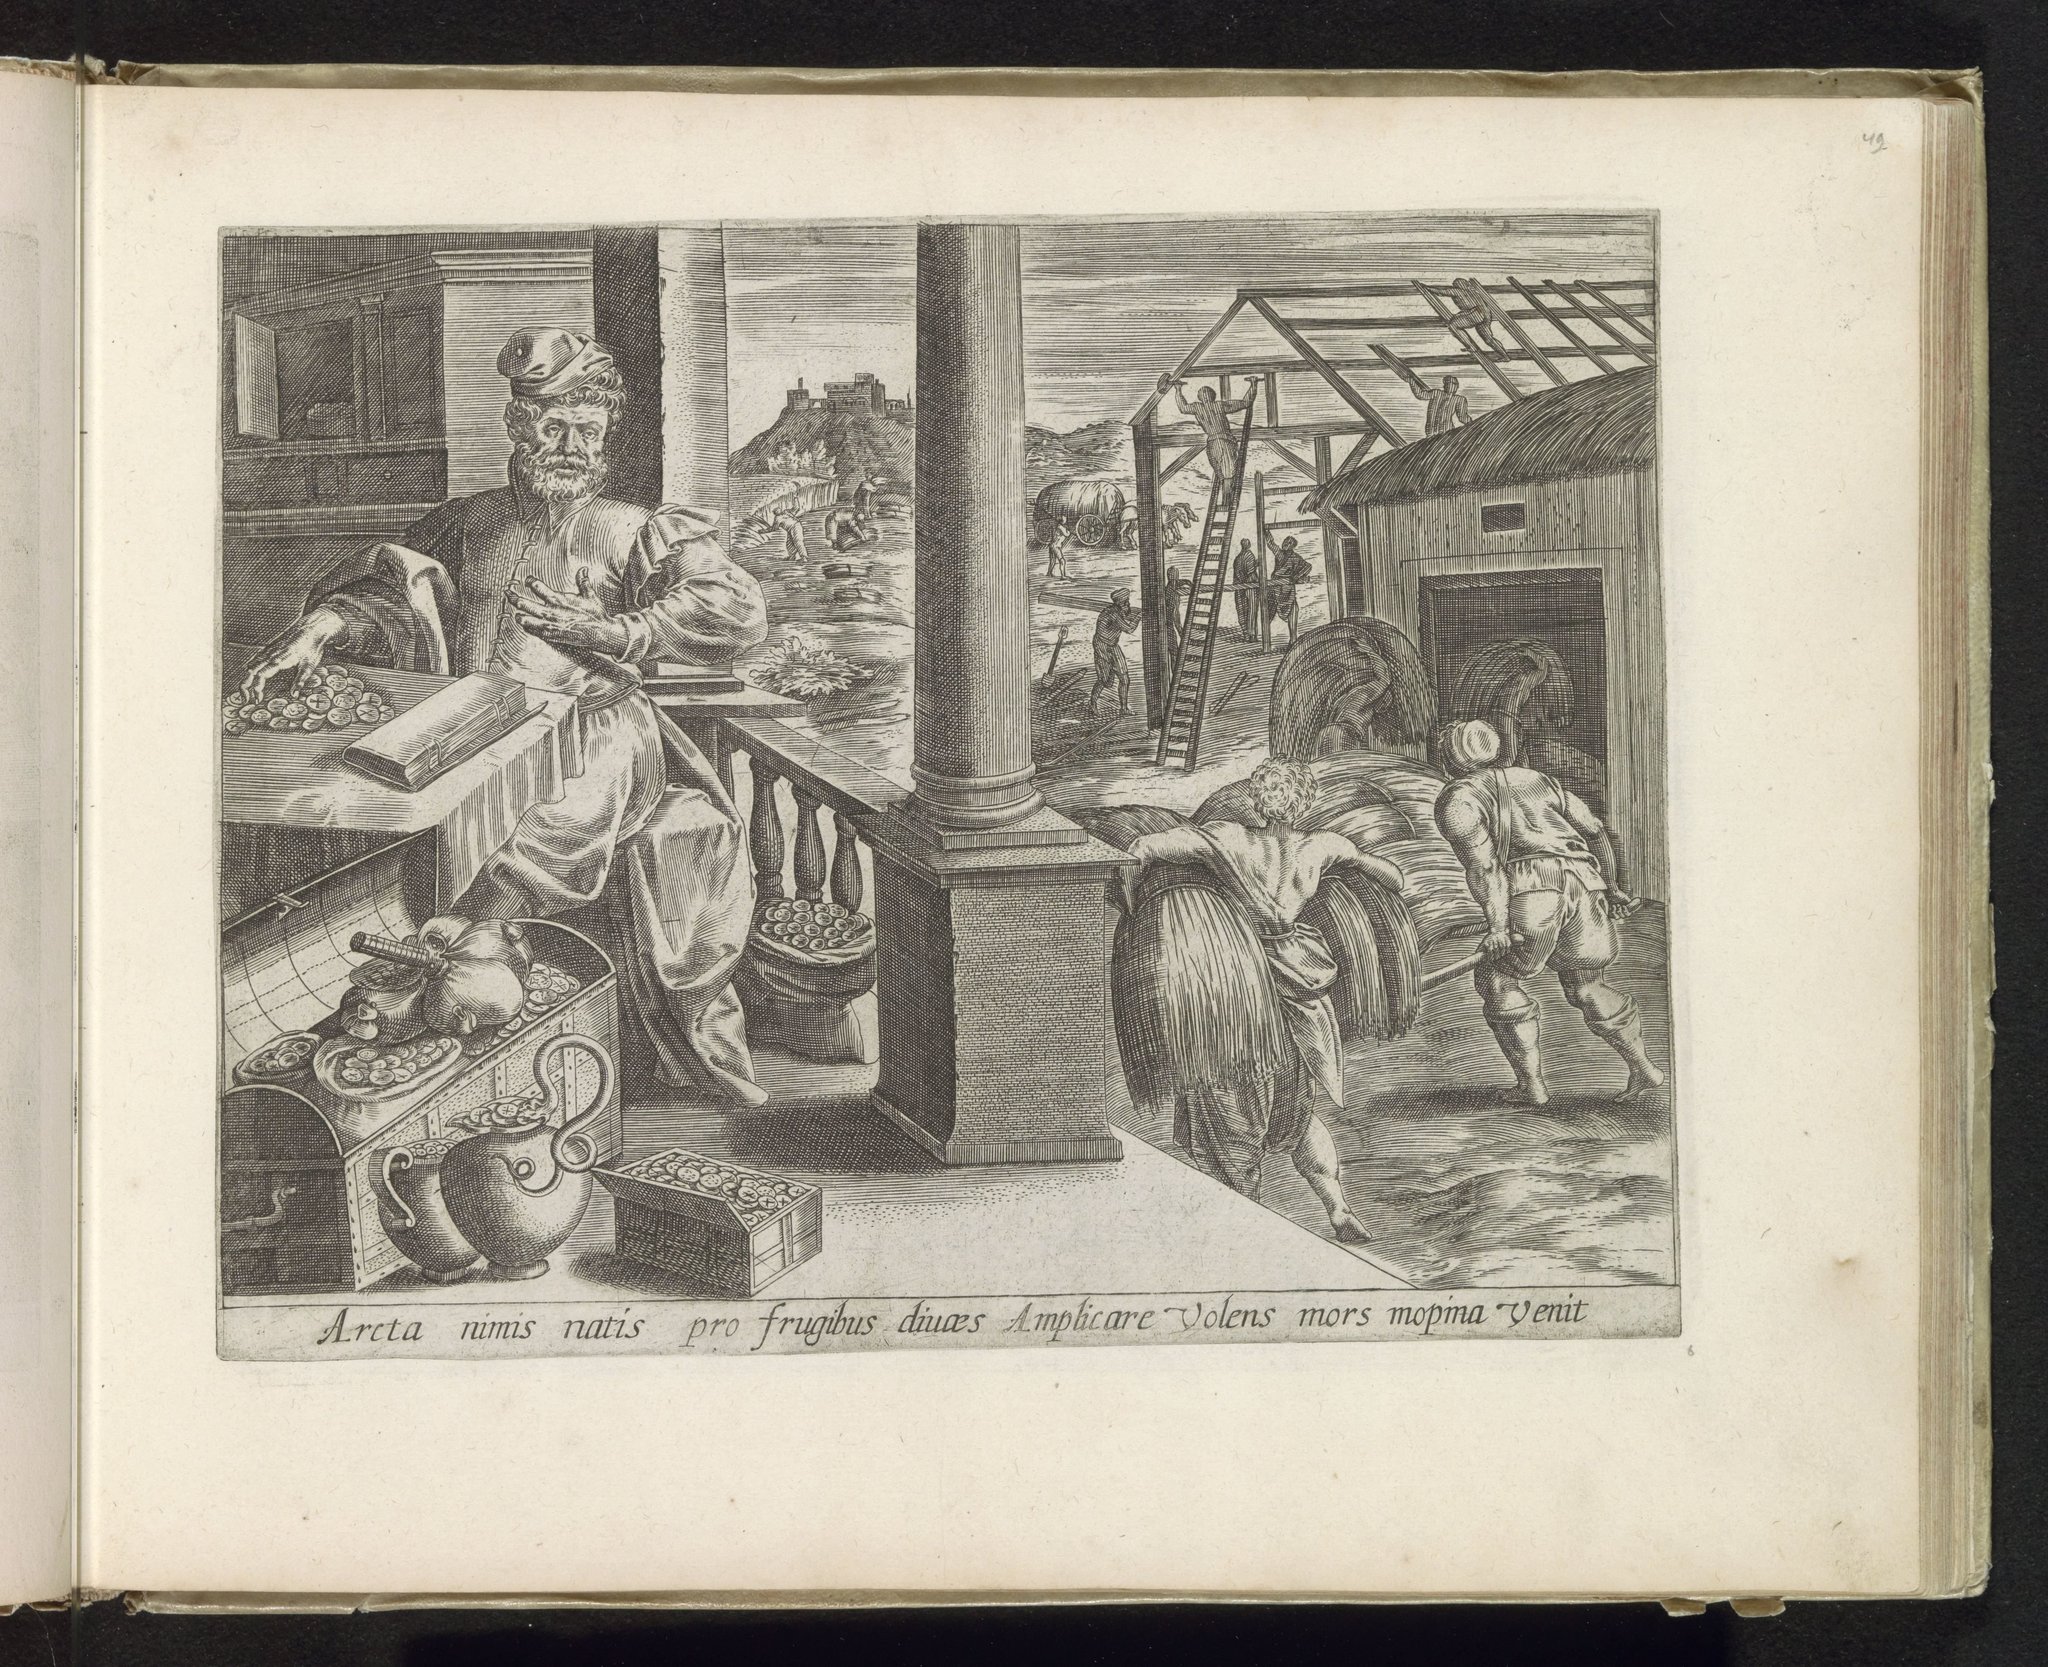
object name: print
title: Gelijkenis van de rijke dwaas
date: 1585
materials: paper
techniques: engraving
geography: antwerp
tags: purse, money-bag, the rich fool, whose death comes when he has saved all his money to build new barns (luke 12:16-21)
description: Een rijke man laat nog grotere schuren bouwen voor zijn rijkdommen en zijn graan. Hij zit aan tafel tussen zijn geld. In de geopende kist ligt een stokbeurs. Onder de voorstelling een verwijzing in het Latijn naar de Bijbeltekst in Luc. 12:16 en naar het vervolg van het verhaal: de rijke man zal 's nachts sterven. Deze prent maakt deel uit van een album.